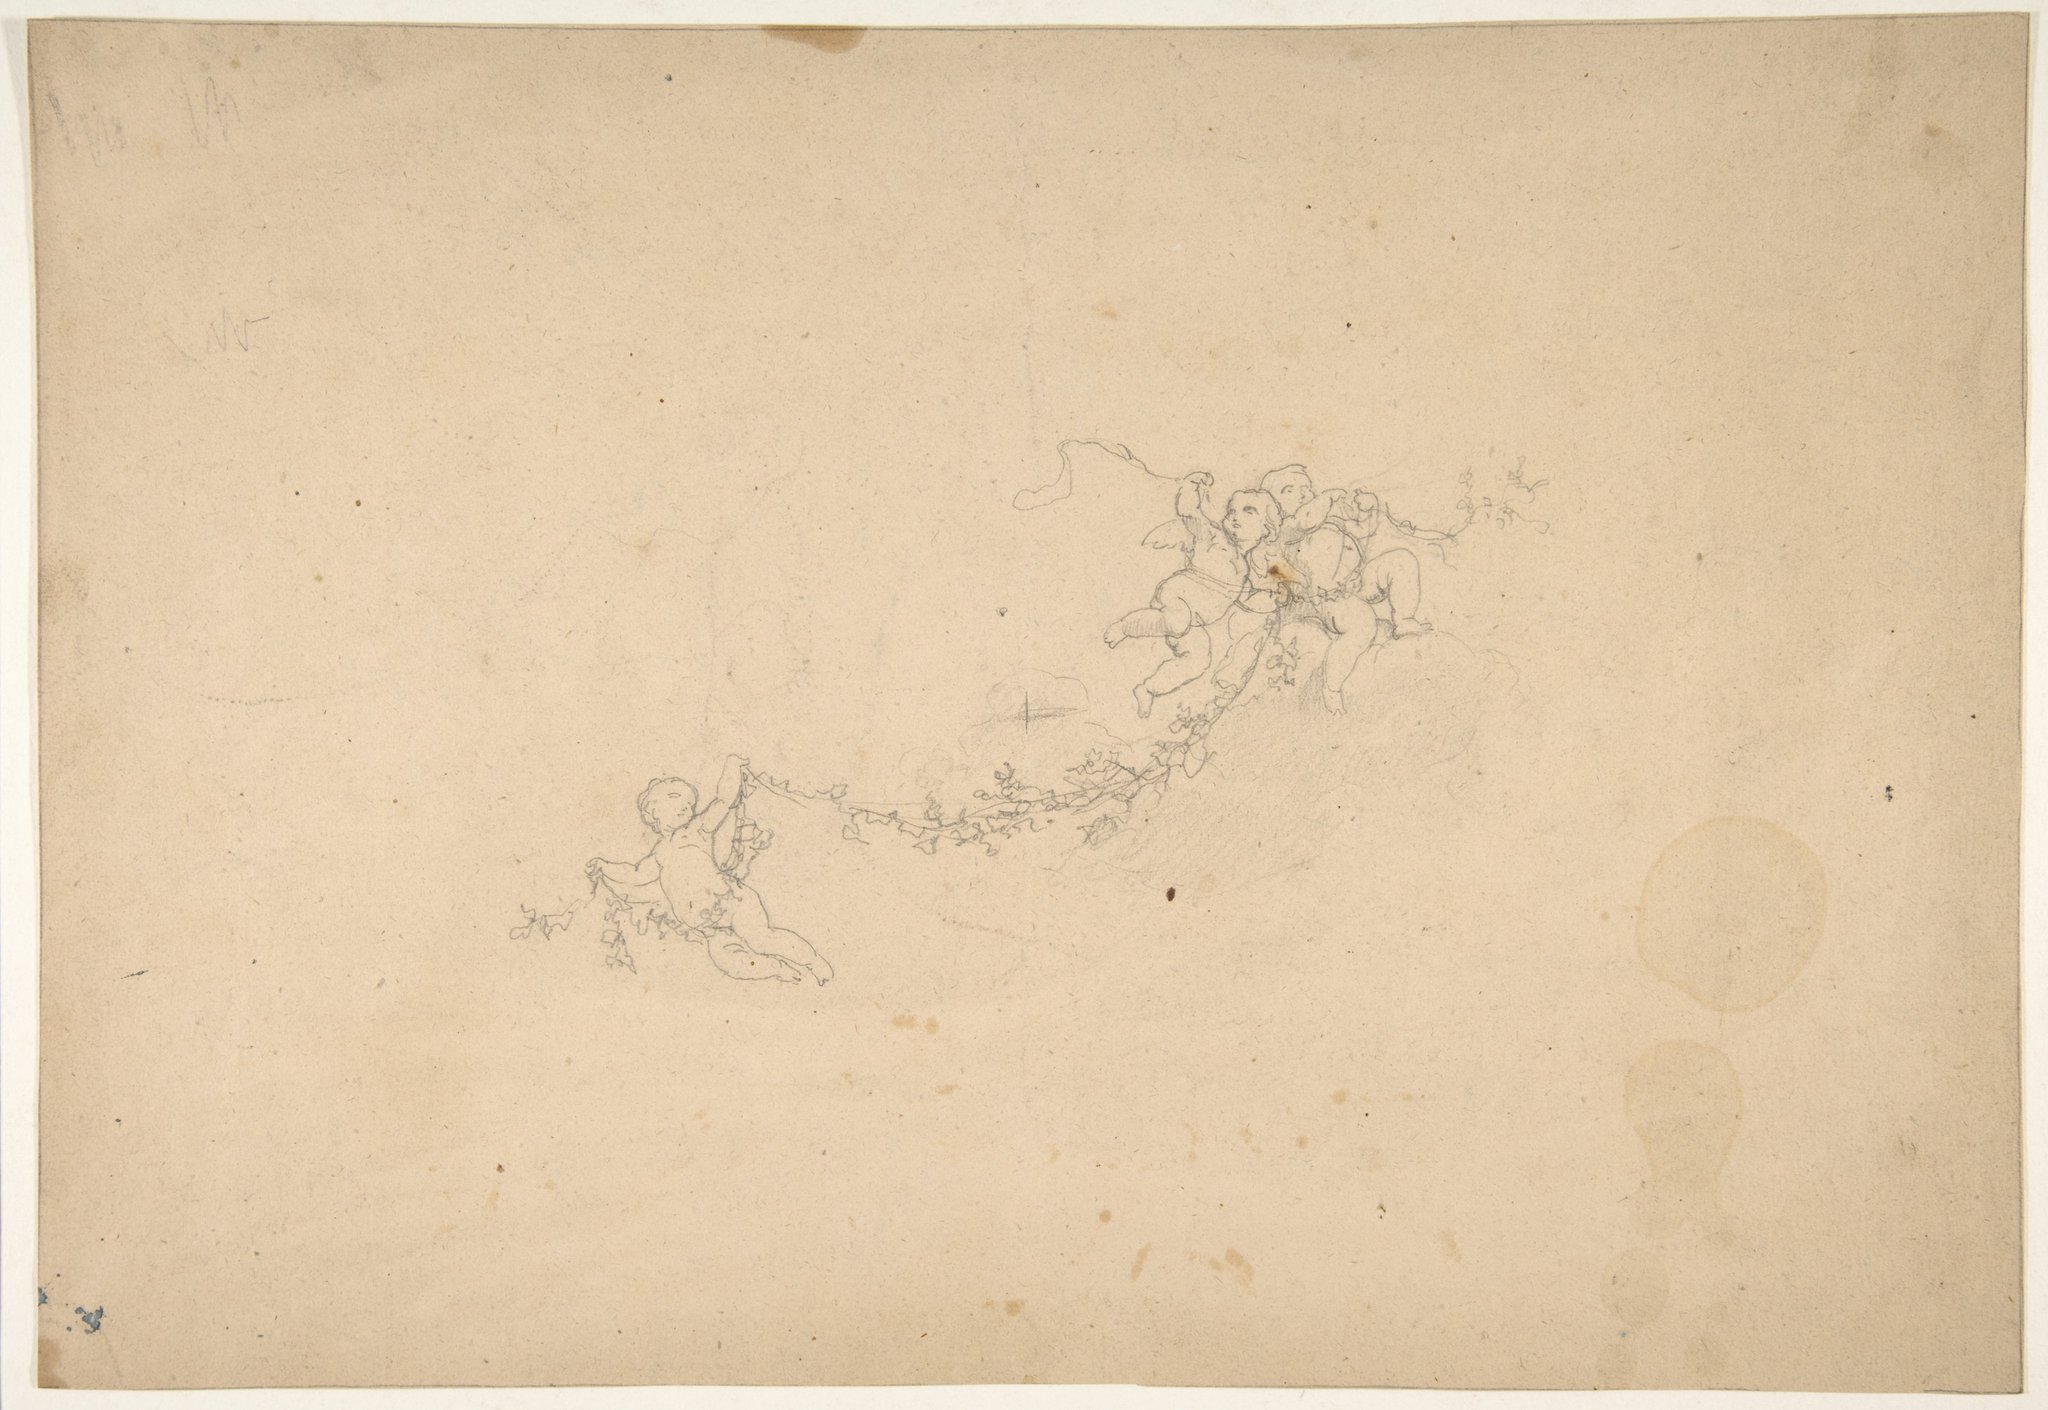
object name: drawing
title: Three putti holding aloft a garland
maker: jules-edmond-charles lachaise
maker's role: artist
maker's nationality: french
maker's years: 1897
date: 1851-1900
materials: graphite, paper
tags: garlands,putti